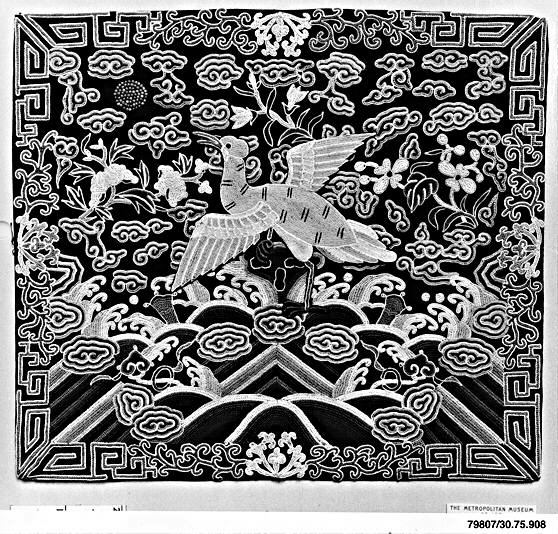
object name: woman's rank badge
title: Woman's Rank Badge with Wild Goose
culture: chinese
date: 1767-1833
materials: silk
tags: geese